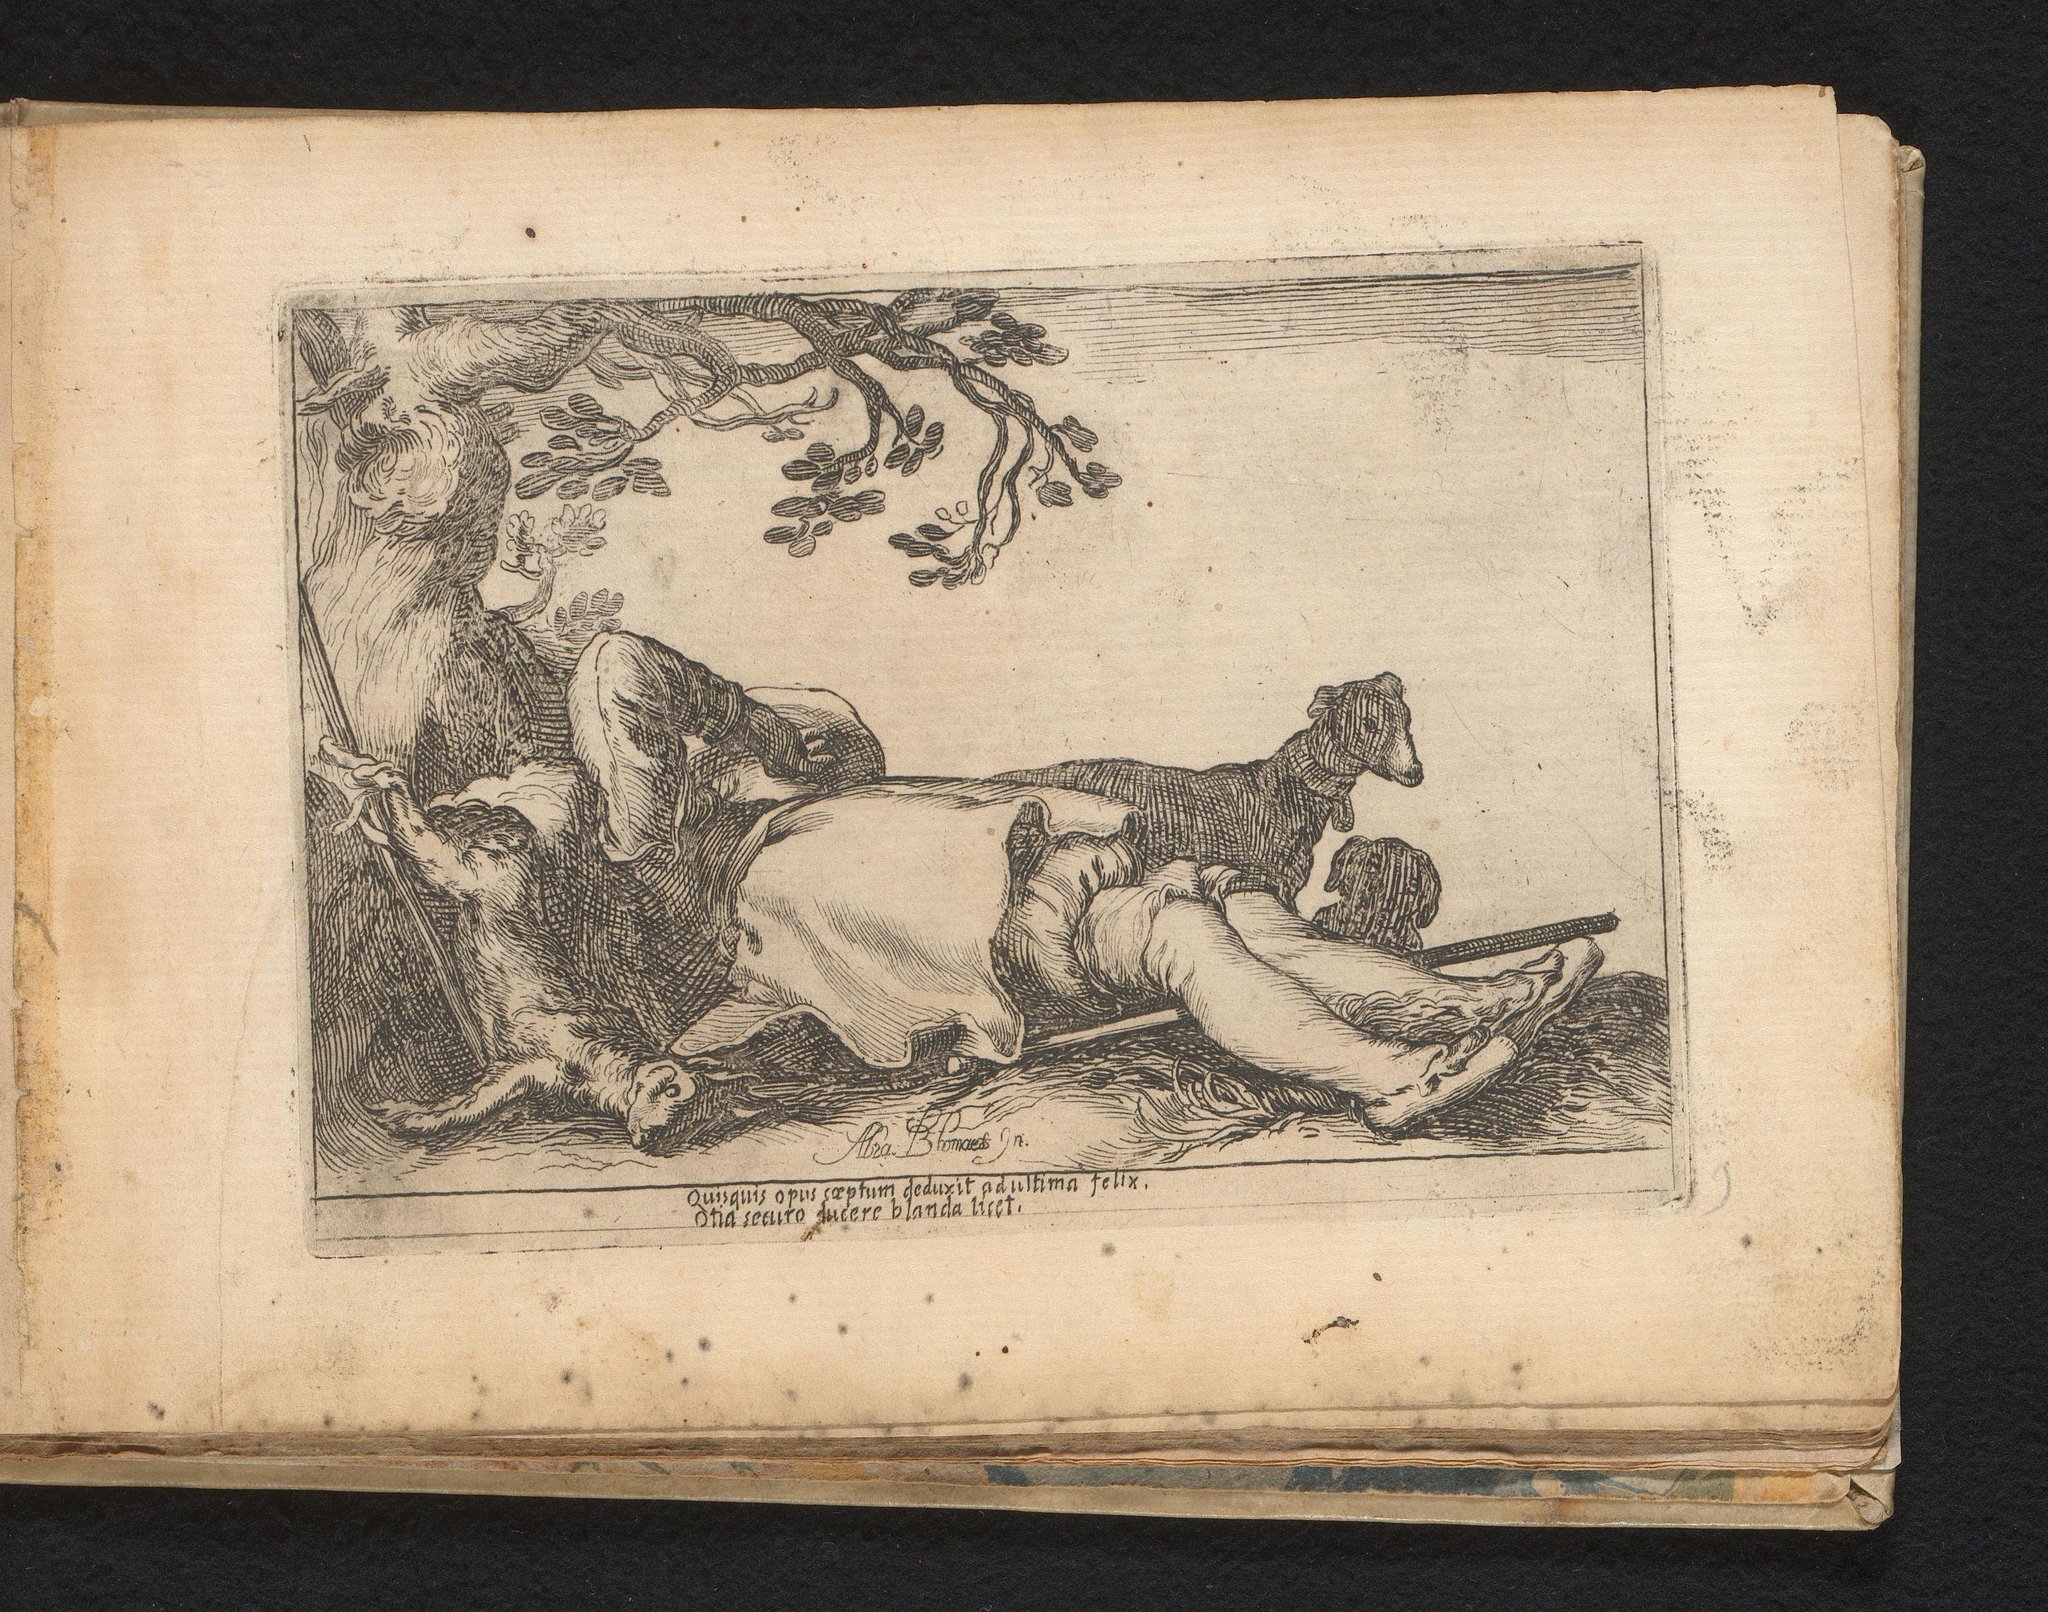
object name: print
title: Slapende jager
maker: Anonymous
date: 1629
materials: ink, paper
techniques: engraving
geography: europe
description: Een man ligt tegen een boom uit te rusten. Naast hem staan twee honden, aan een stok hangt een dode haas. Met tweeregelig vers in het Latijn in ondermarge. Het betreft de serie getiteld: Otia delectant faciuntq [...]. Kalfsleren band met opschrift en decoratieve kaderlijnen in pen in bruin. Voorin en achterin vier schutbladen van velijn.